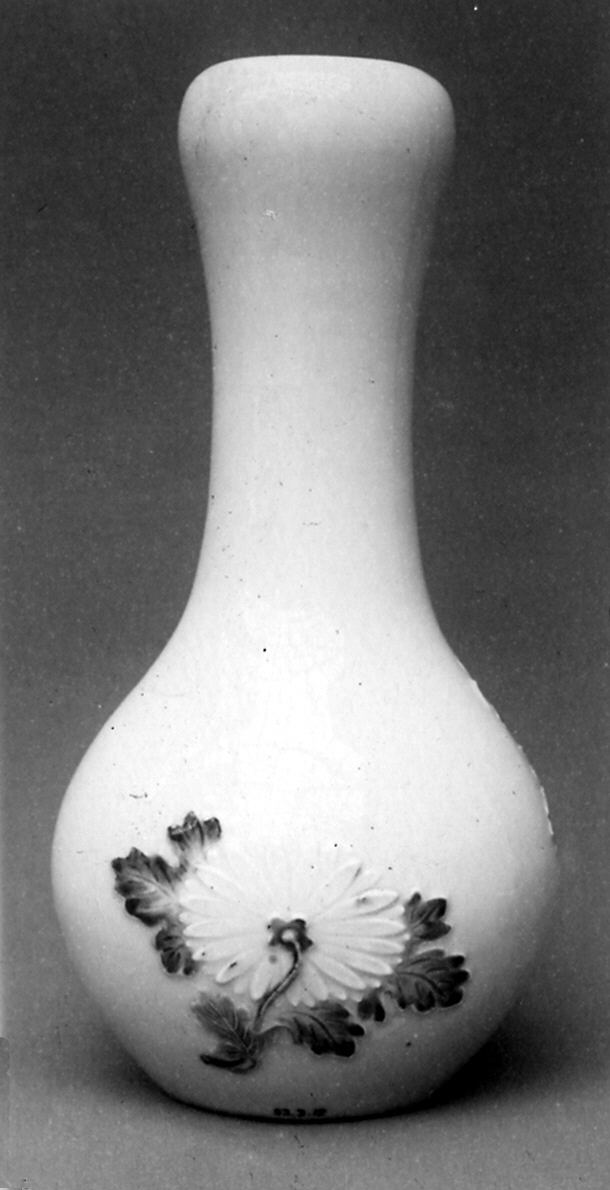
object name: vase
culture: japanese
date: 1760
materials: glaze, porcelain